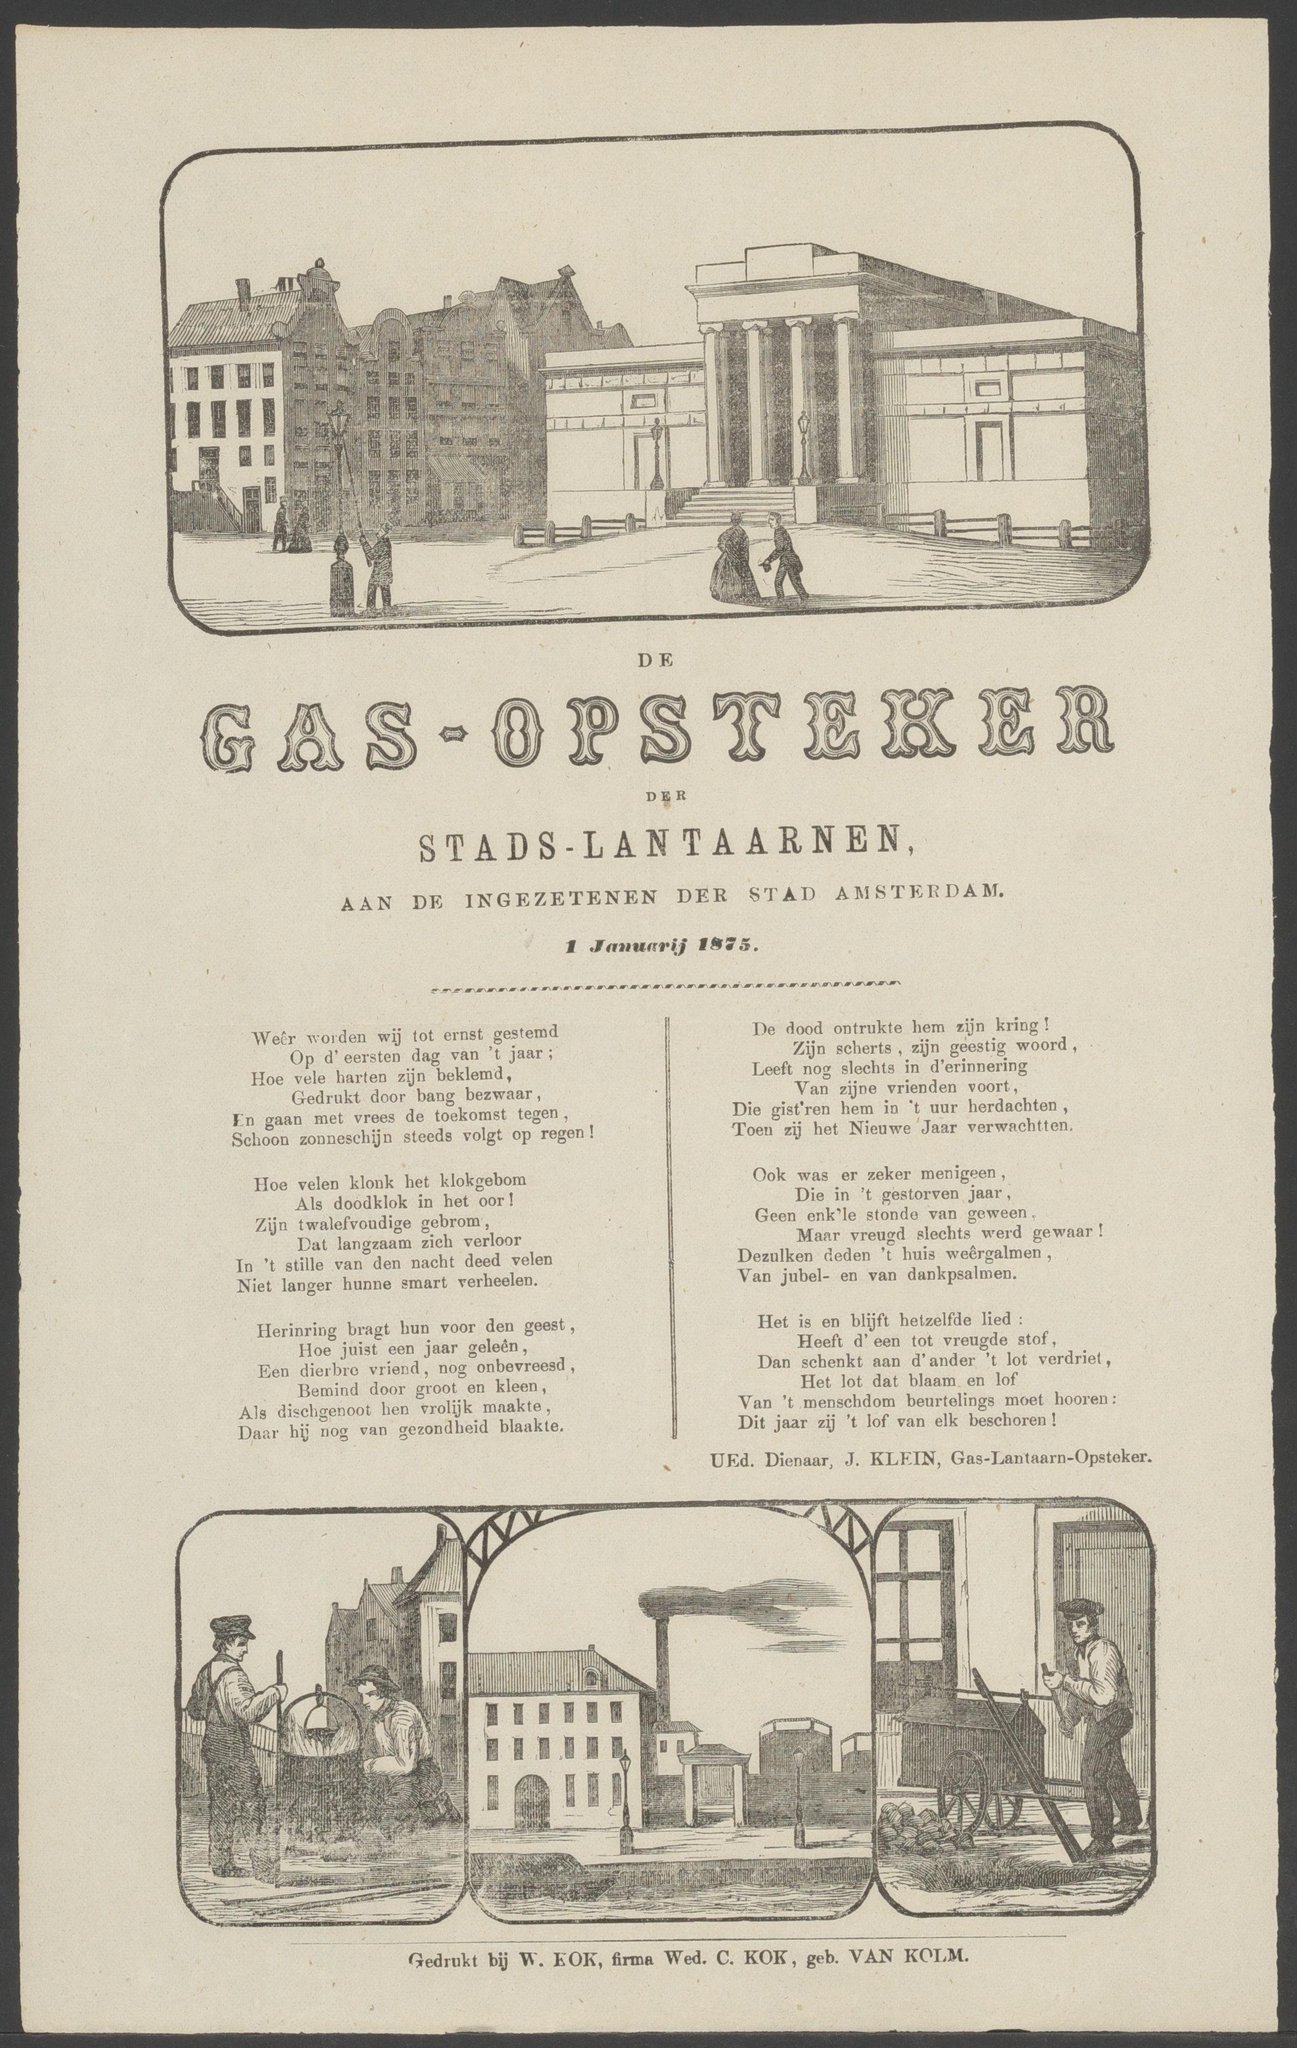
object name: new year card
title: Nieuwjaarswens van de gaslantaarnopstekers van Amsterdam voor het jaar 1875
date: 1874-1875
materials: paper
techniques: letterpress printing, engraving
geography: amsterdam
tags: gas-lamp, gas supply, digging (industrial process), street lighting, amsterdam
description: Nieuwjaarswens van de Amsterdamse gaslantaarnopstekers voor het jaar 1875. Centraal een vers in twee kolommen. Bovenaan de Dam met de beurs van Zocher te Amsterdam. Onderaan de Hollandsche Gasfabriek en twee gasfitters aan het werk. Van de gaslantaarnopsteker: J. Klein. Onderwerpsrubrieken binnen de Atlas Zeden en Gewoonten: Zeden en gewoonten in engeren zin, Volksleven, Volksbladen, Nieuwjaars- en Kerstwenschen, Amsterdam.